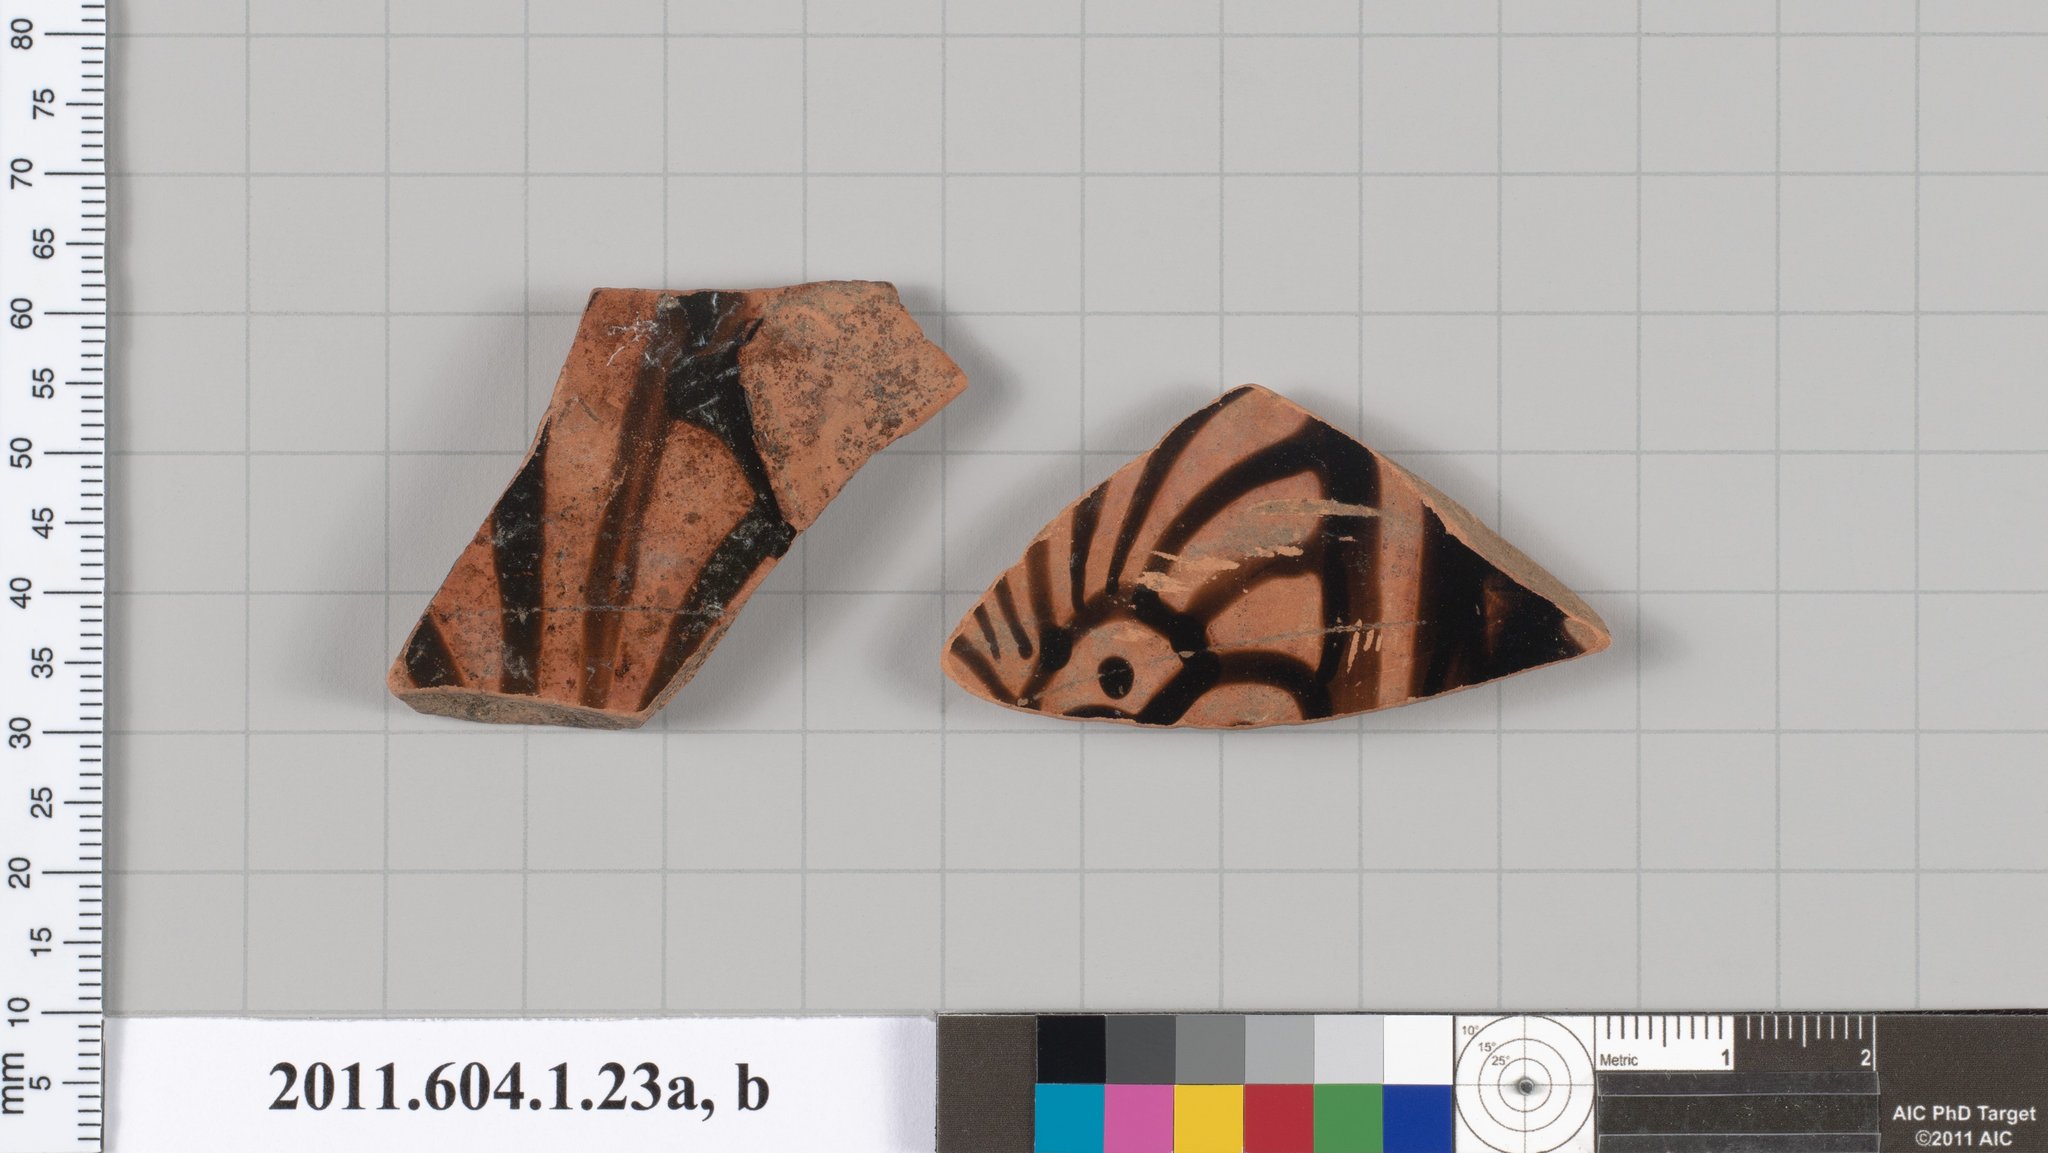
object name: kylix fragment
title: Terracotta fragments of a kylix (drinking cup)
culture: greek, attic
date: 467-435 BCE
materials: terracotta